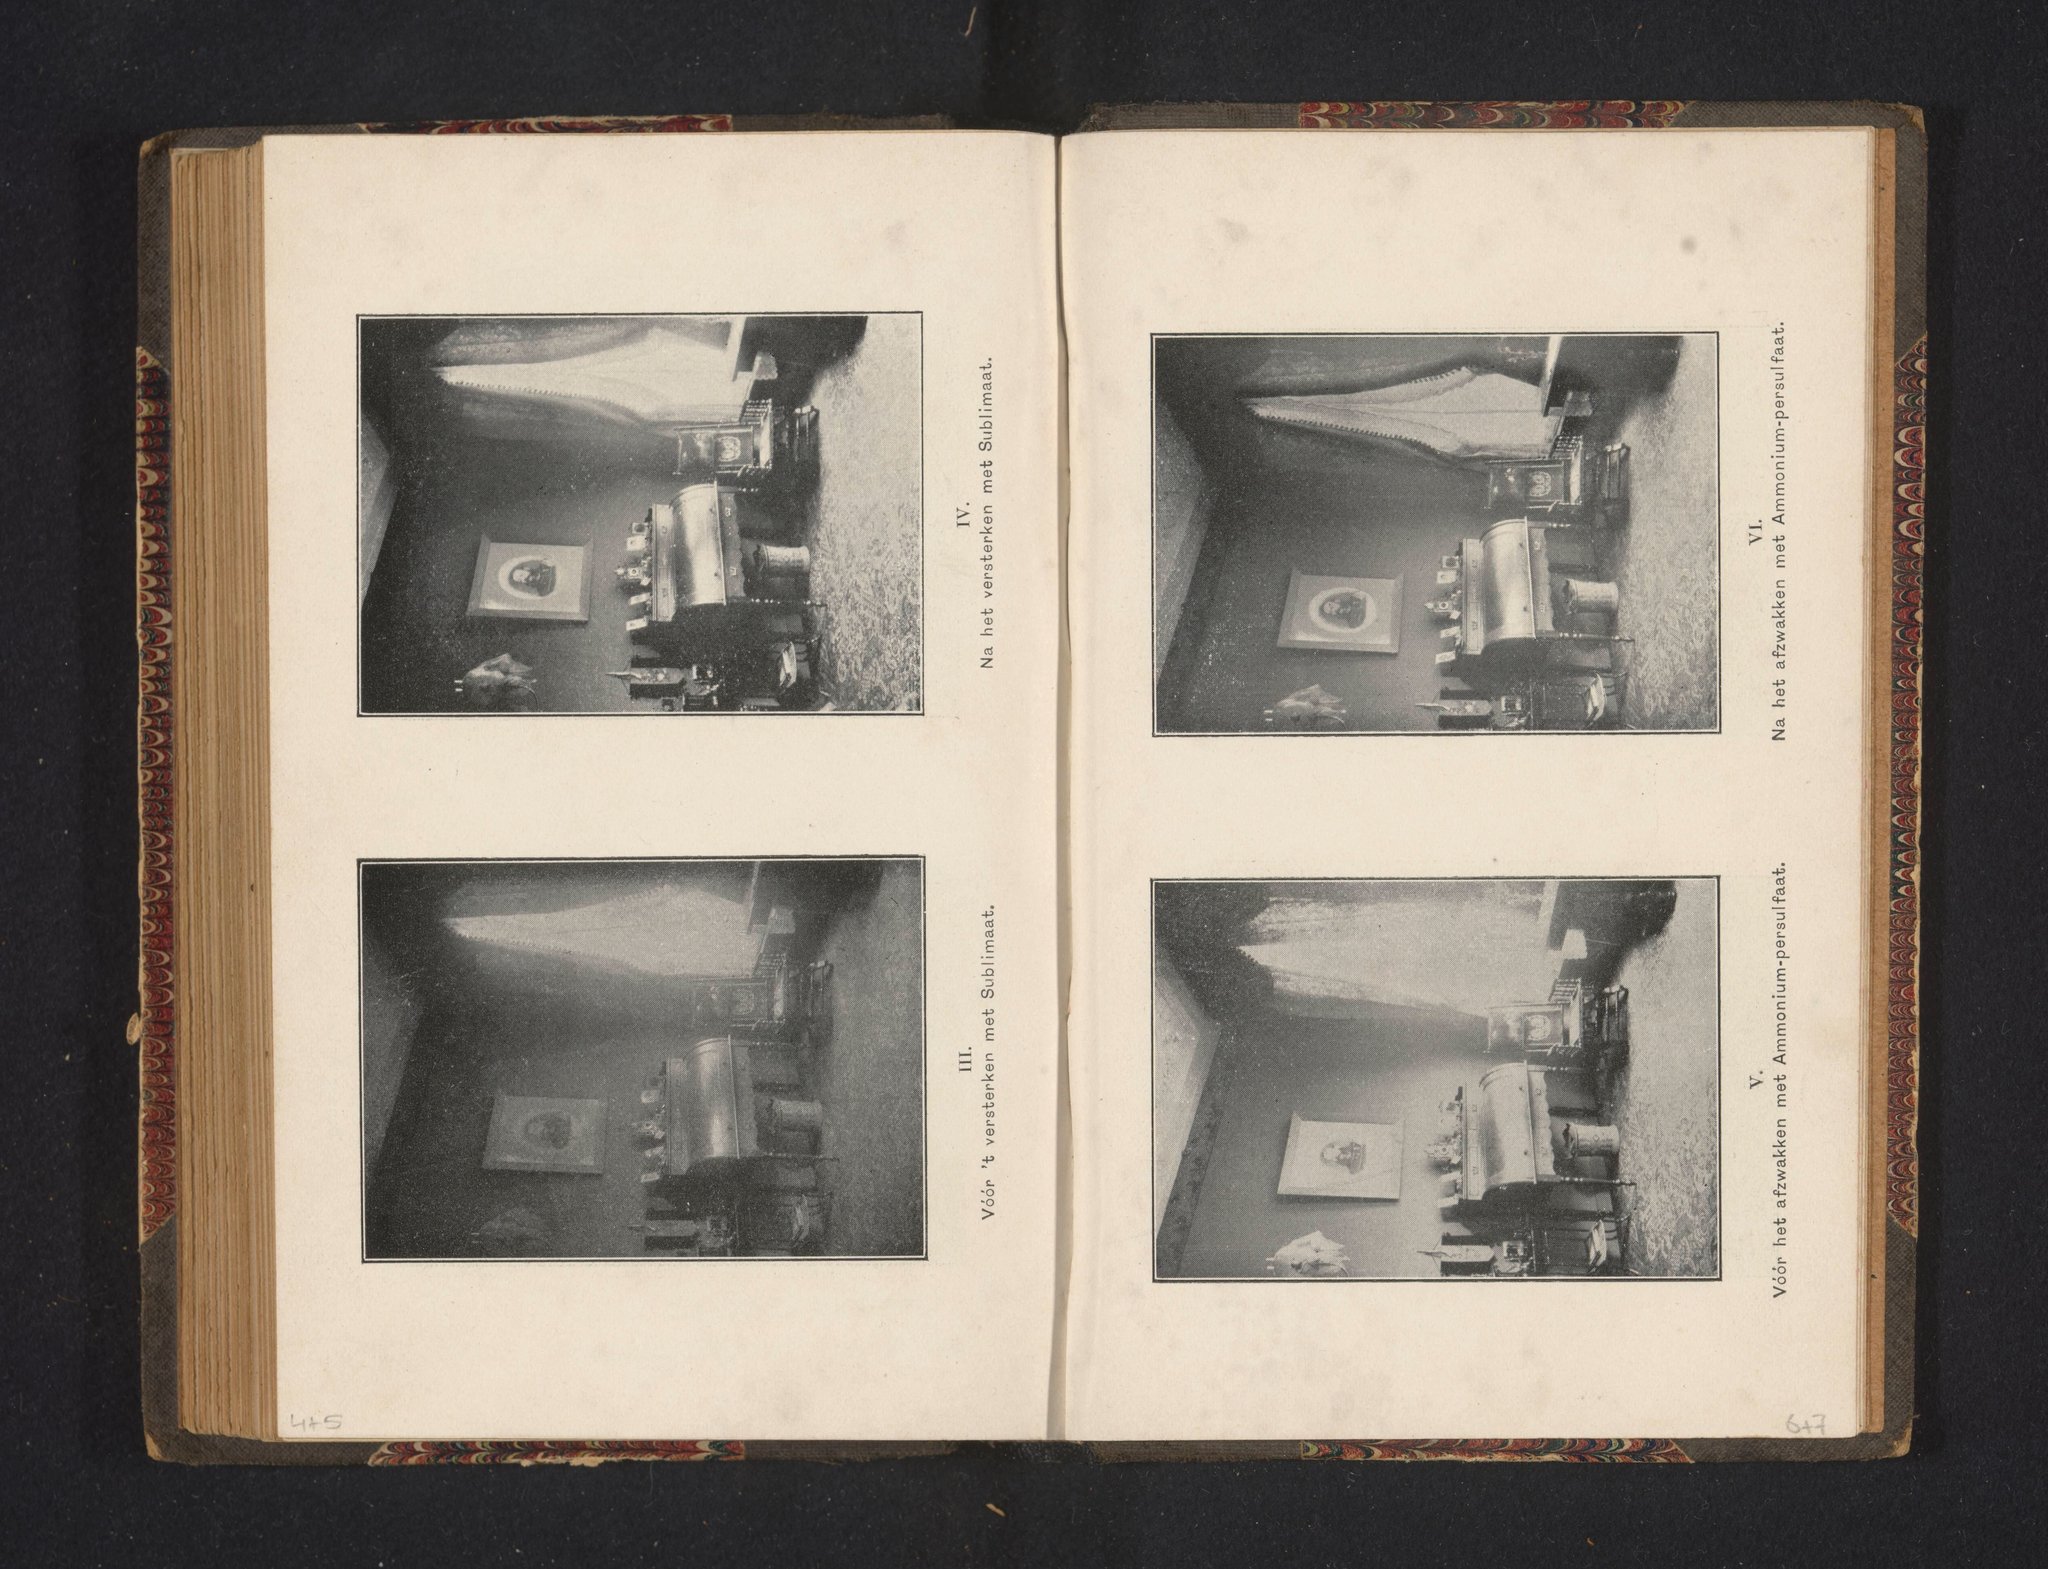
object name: photomechanical print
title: Voorbeeldopname, met daarop een kamer met bureau en stoel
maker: Anonymous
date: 1897-1902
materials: paper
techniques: autotype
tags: writing-table, writing-desk, interior of the house, chair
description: Prent vijf van veertien prenten na pagina 241.